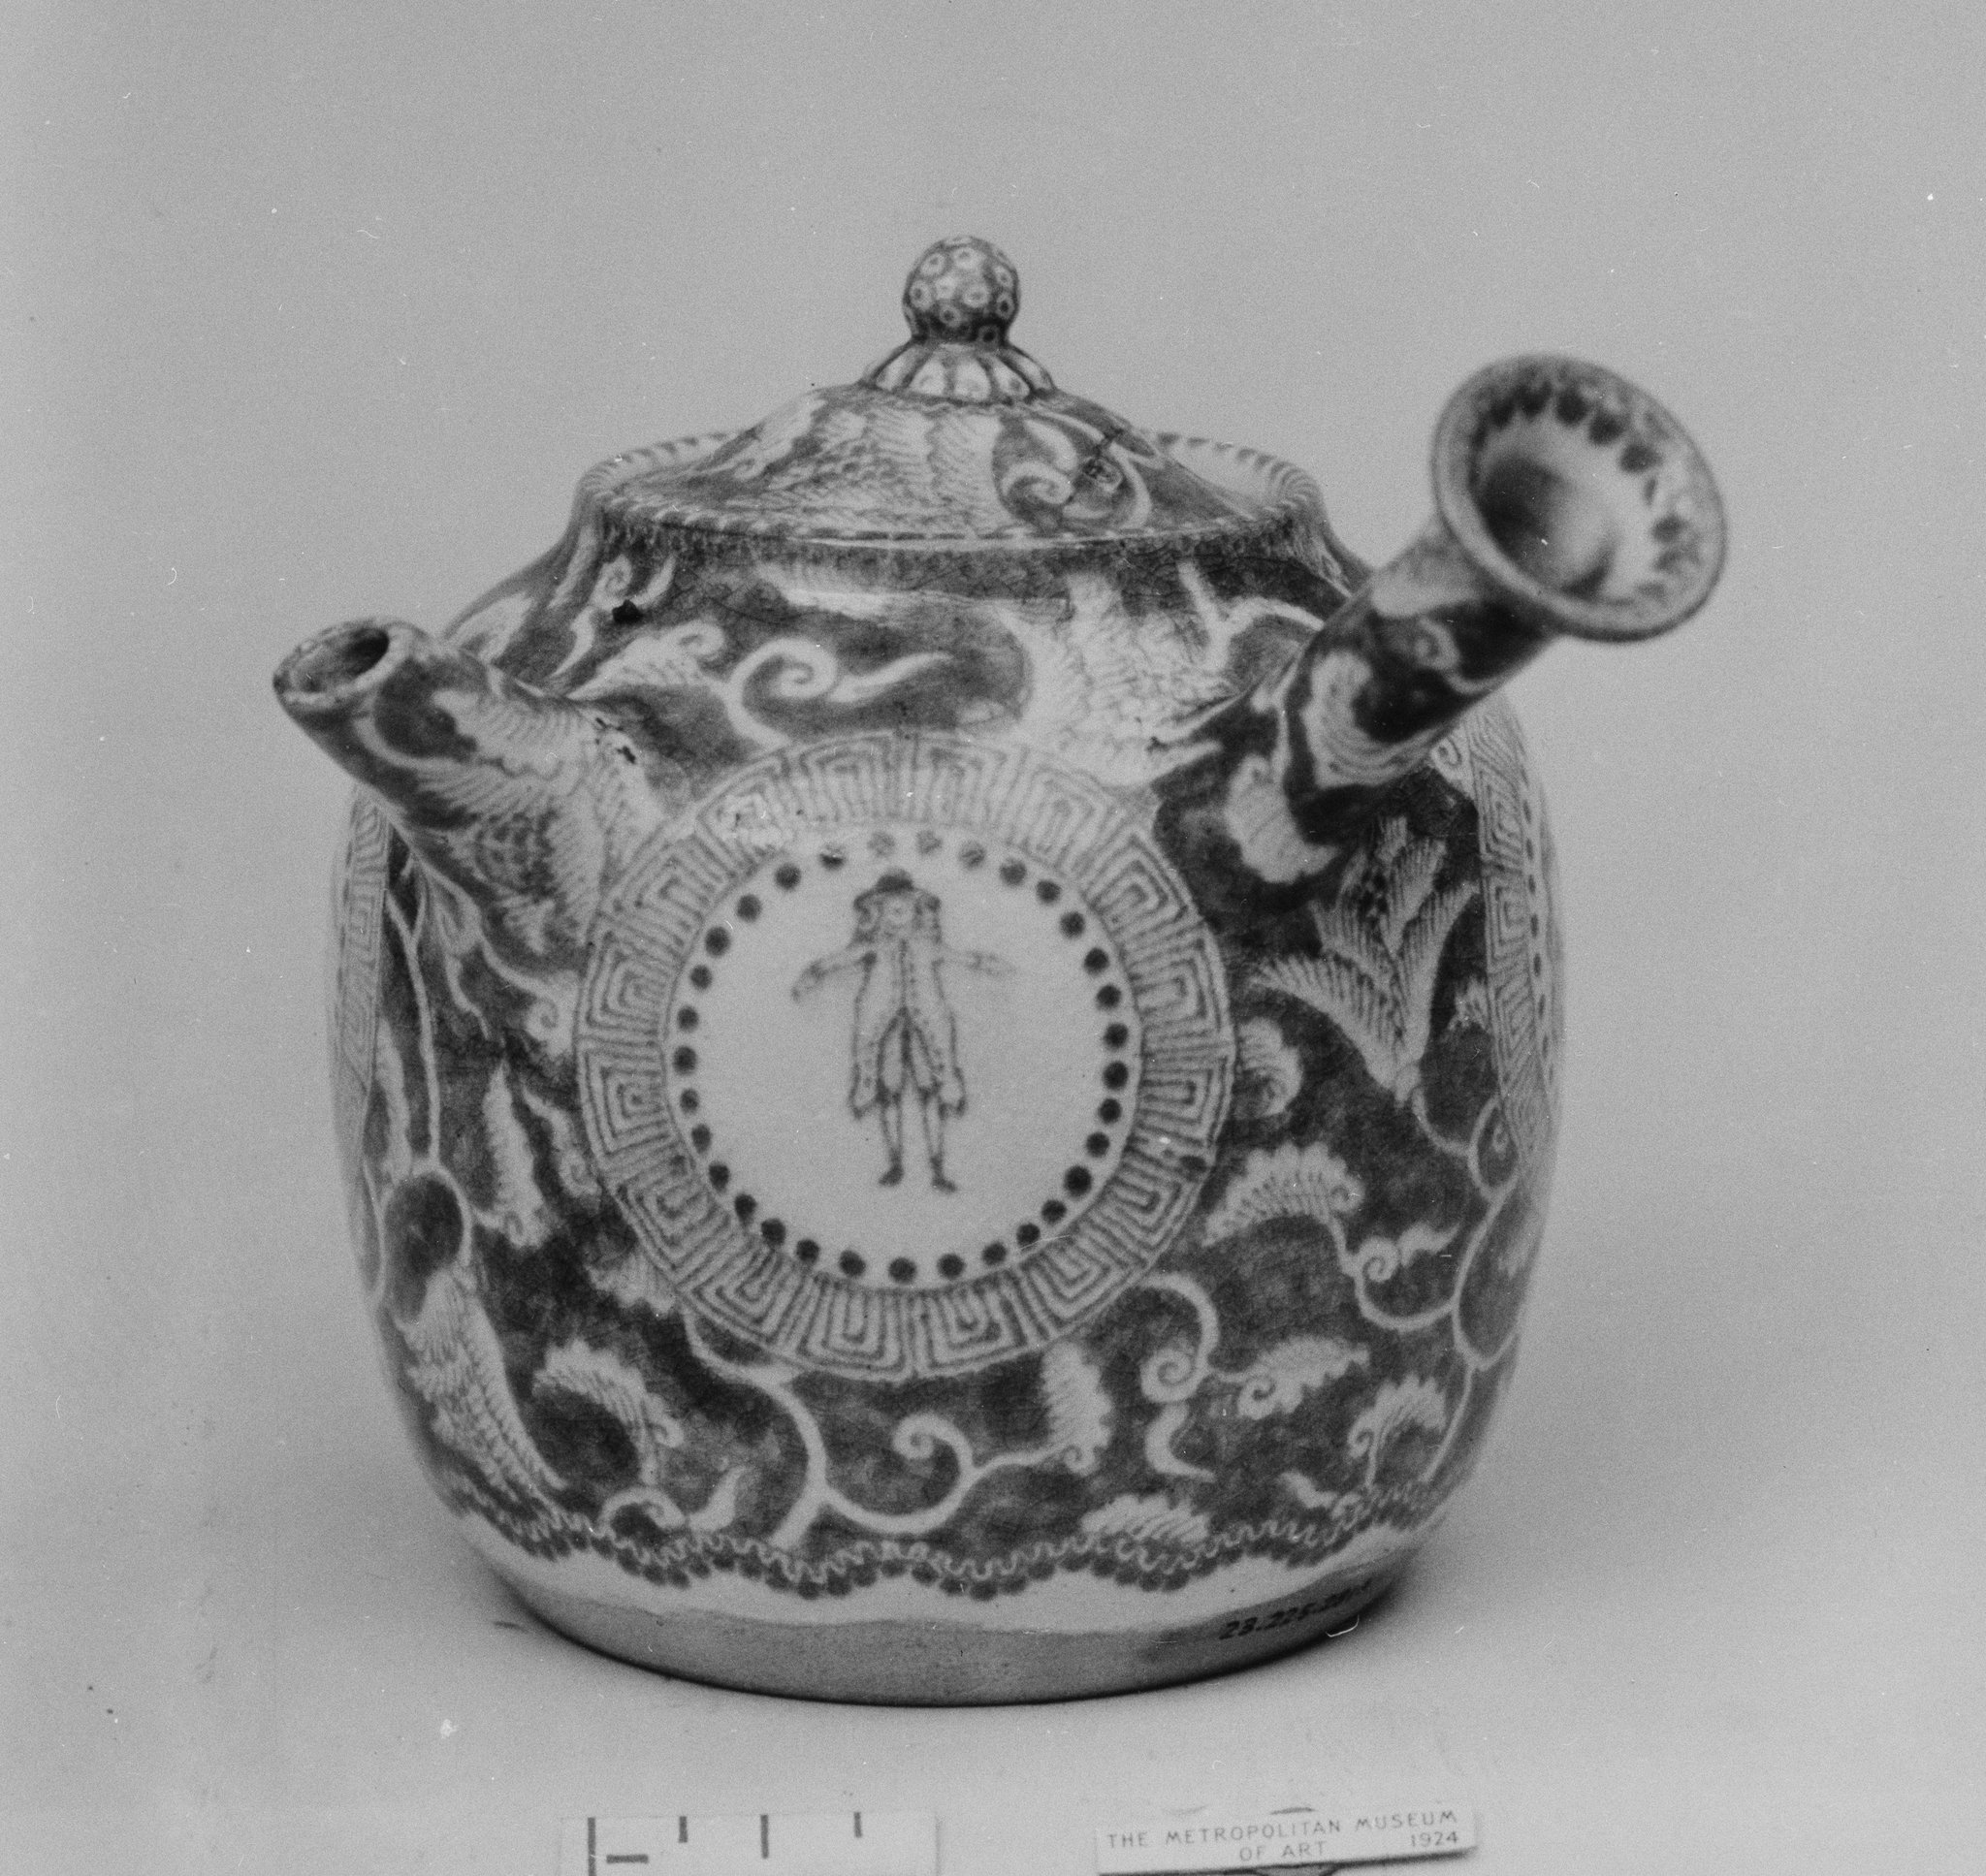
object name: teapot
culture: japanese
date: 1870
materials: faience